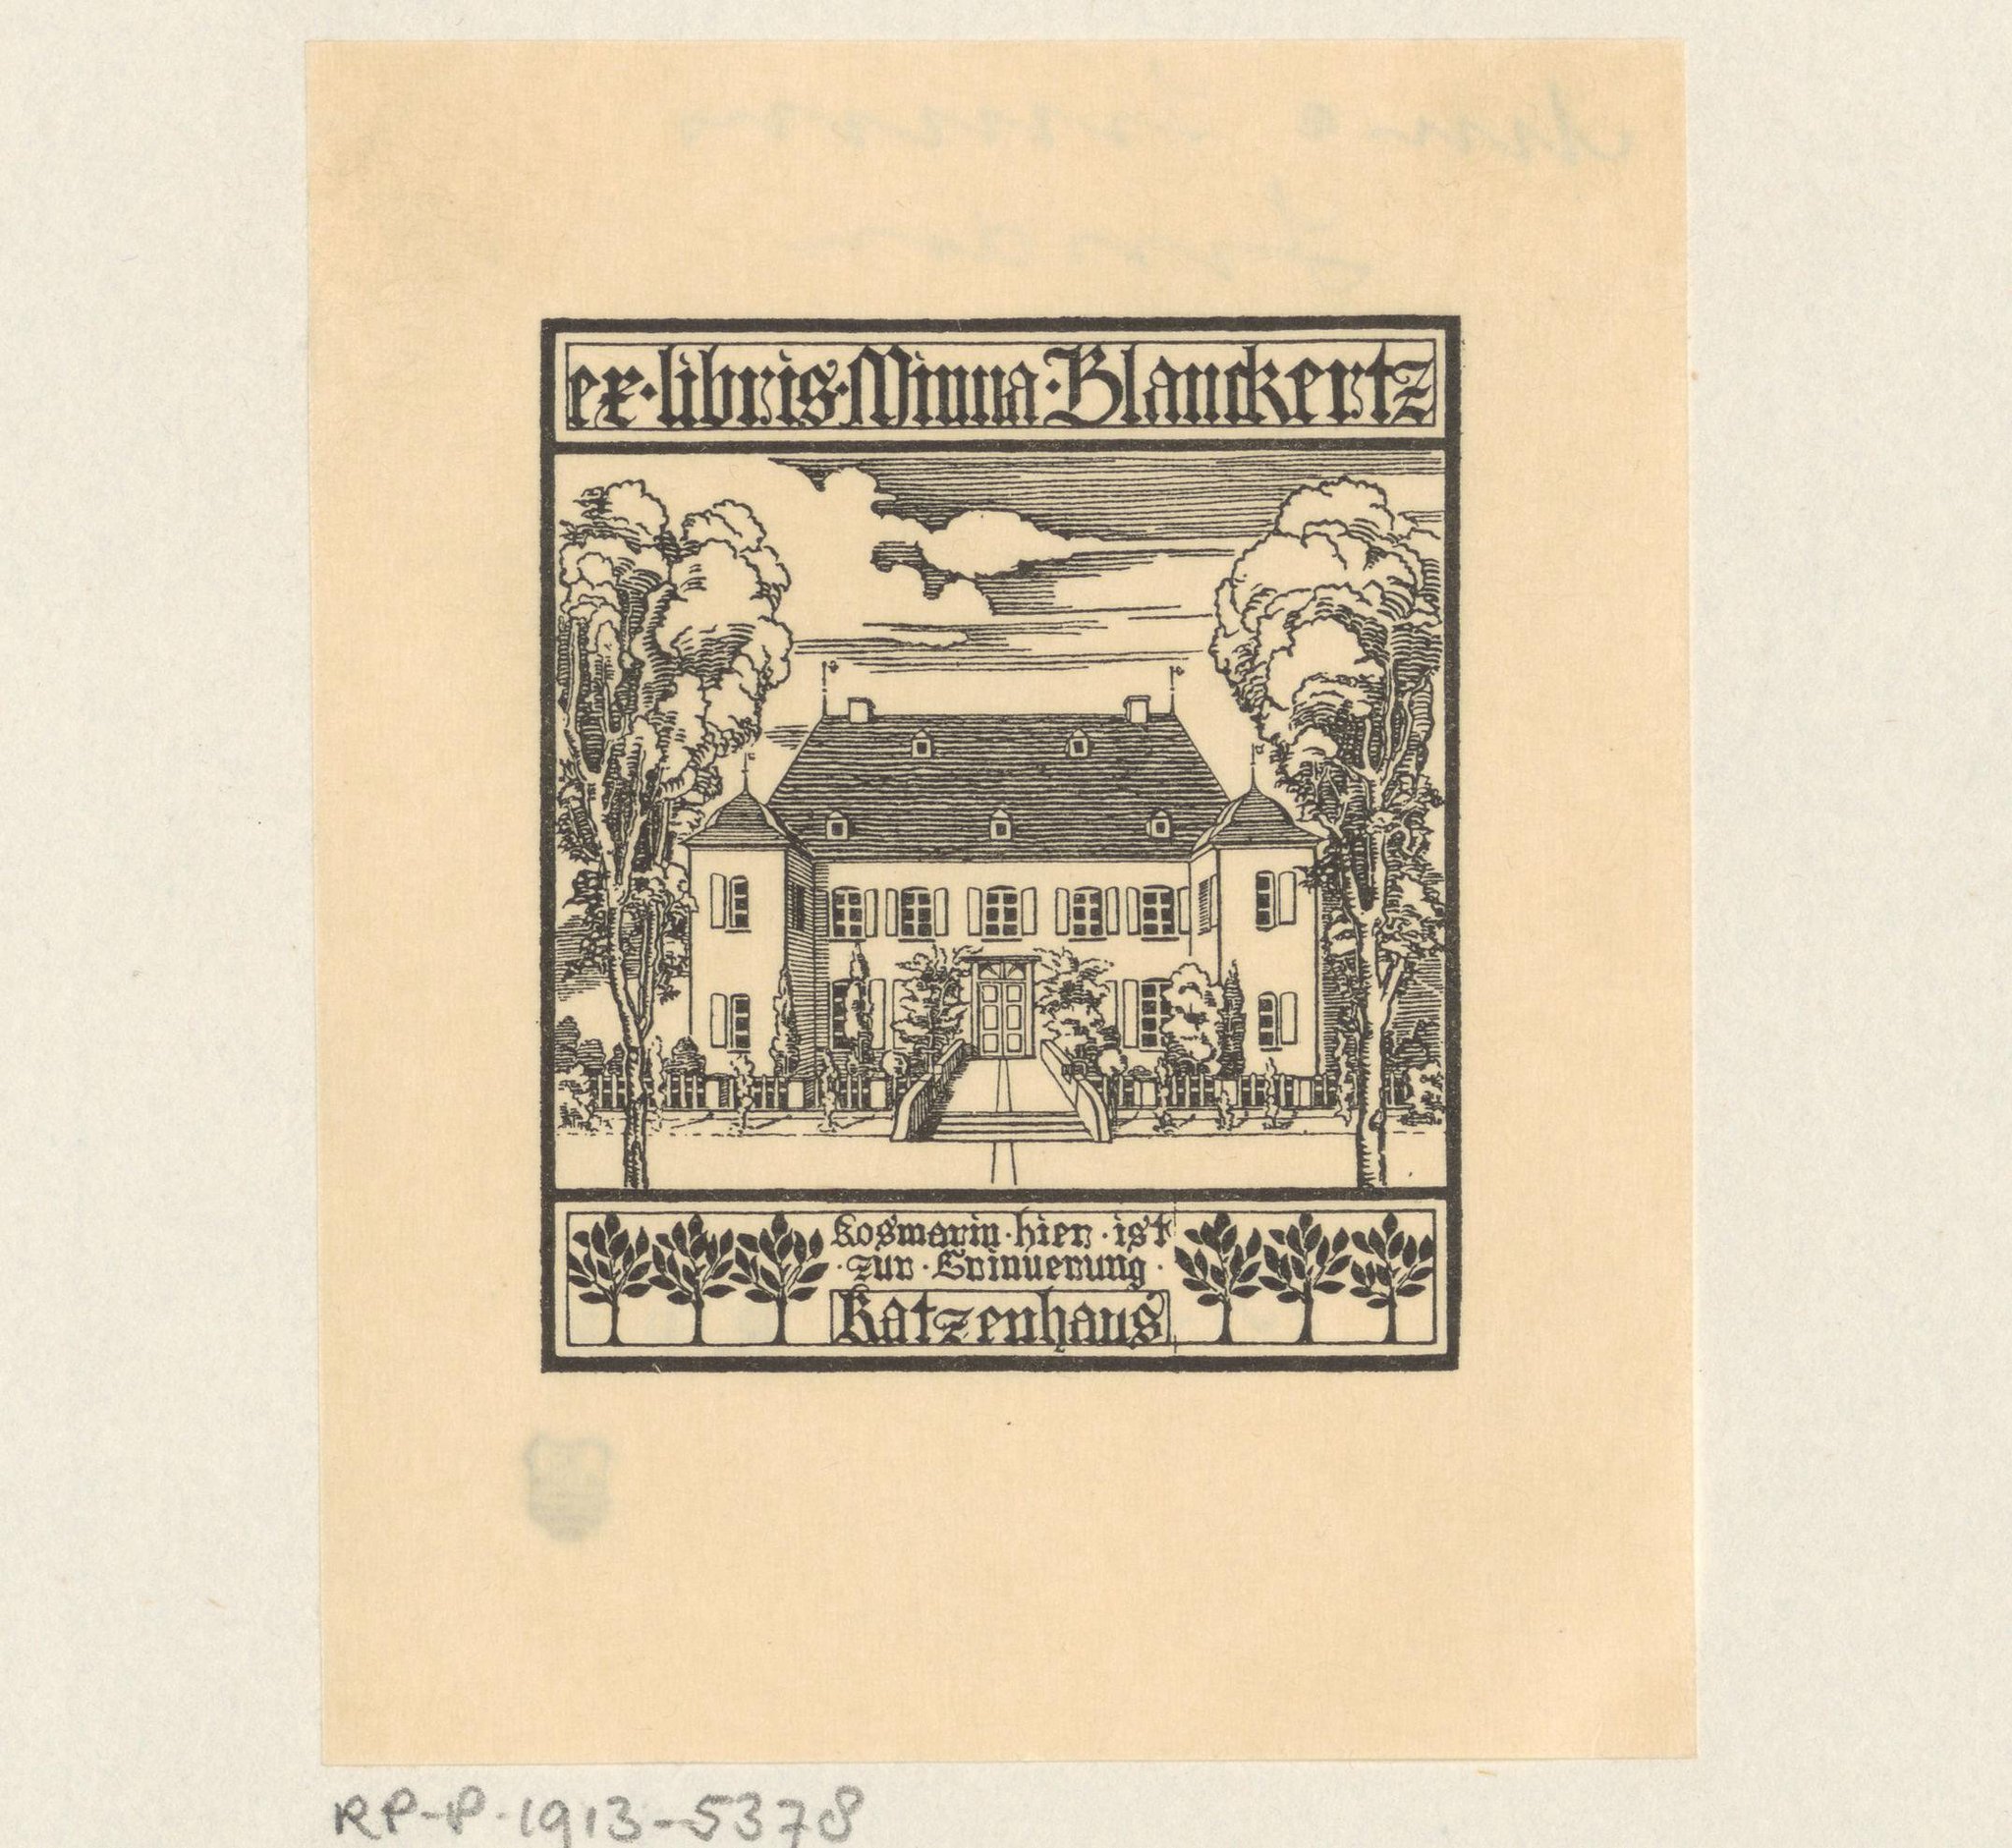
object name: bookplate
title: Ex libris van Minna Blanckertz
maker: Anonymous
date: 1881-1913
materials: paper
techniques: printing block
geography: germany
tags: trees, castle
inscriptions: collector's mark: Lugt 2233, collector's mark: Lugt 2760